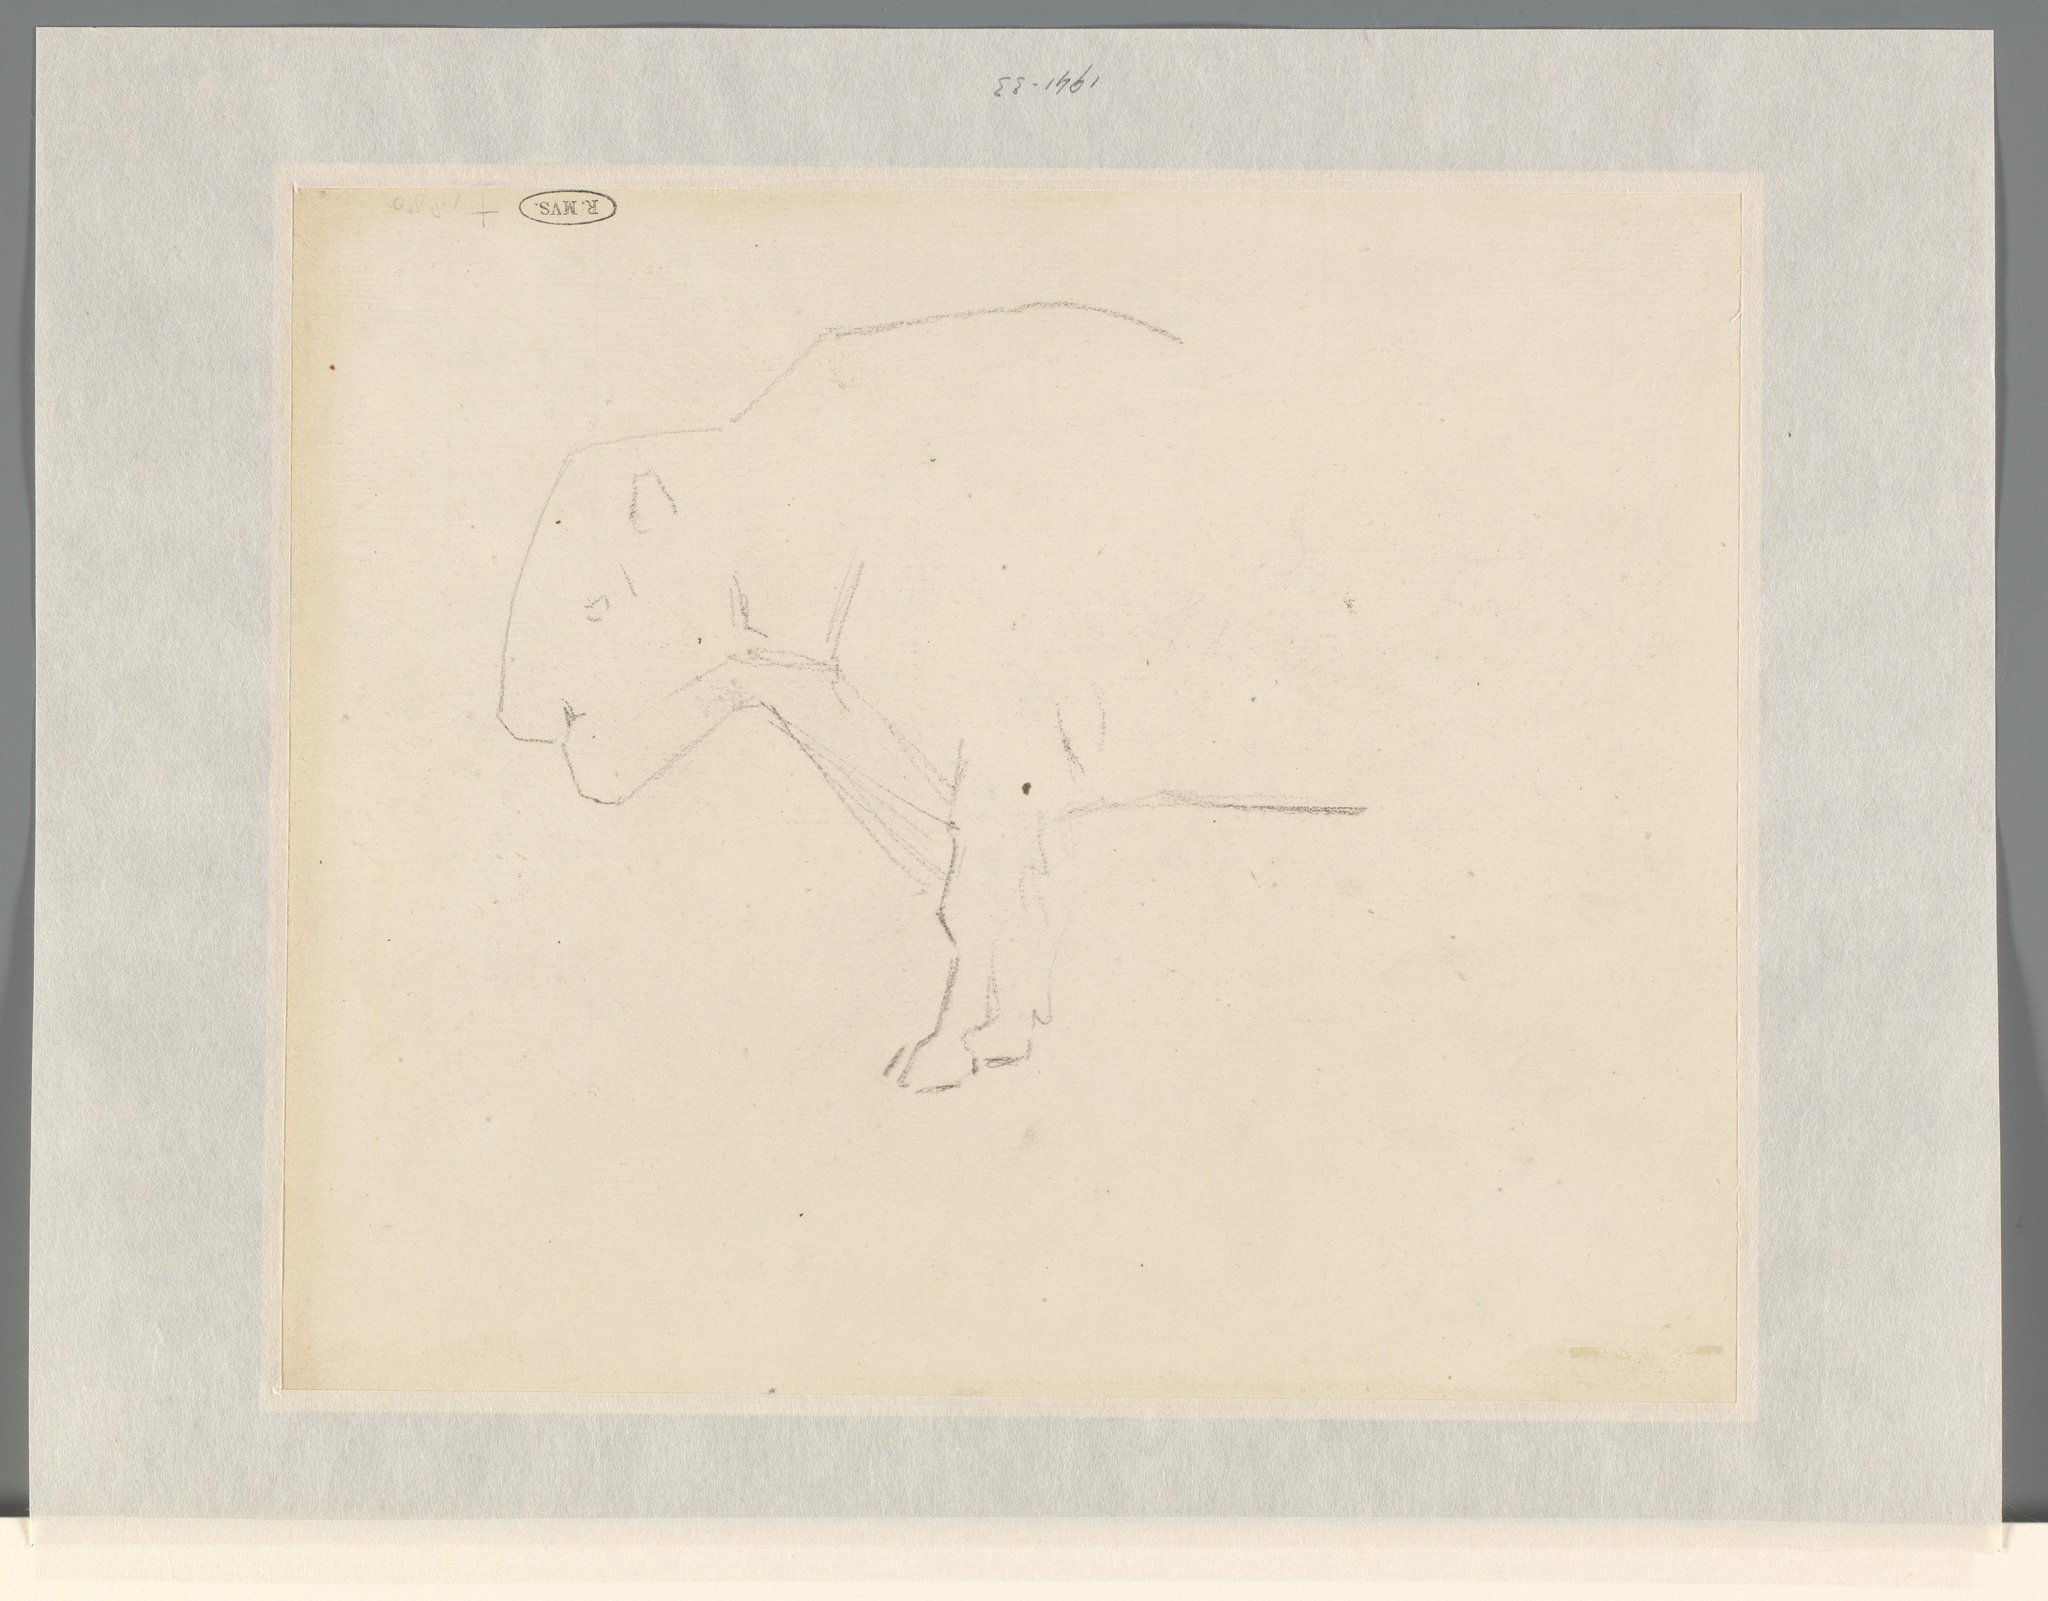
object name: drawing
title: Amerikaanse bizon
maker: piet meiners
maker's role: draughtsman, painter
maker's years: 1857-1903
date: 1867-1903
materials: chalk, paper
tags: hoofed animals: bison